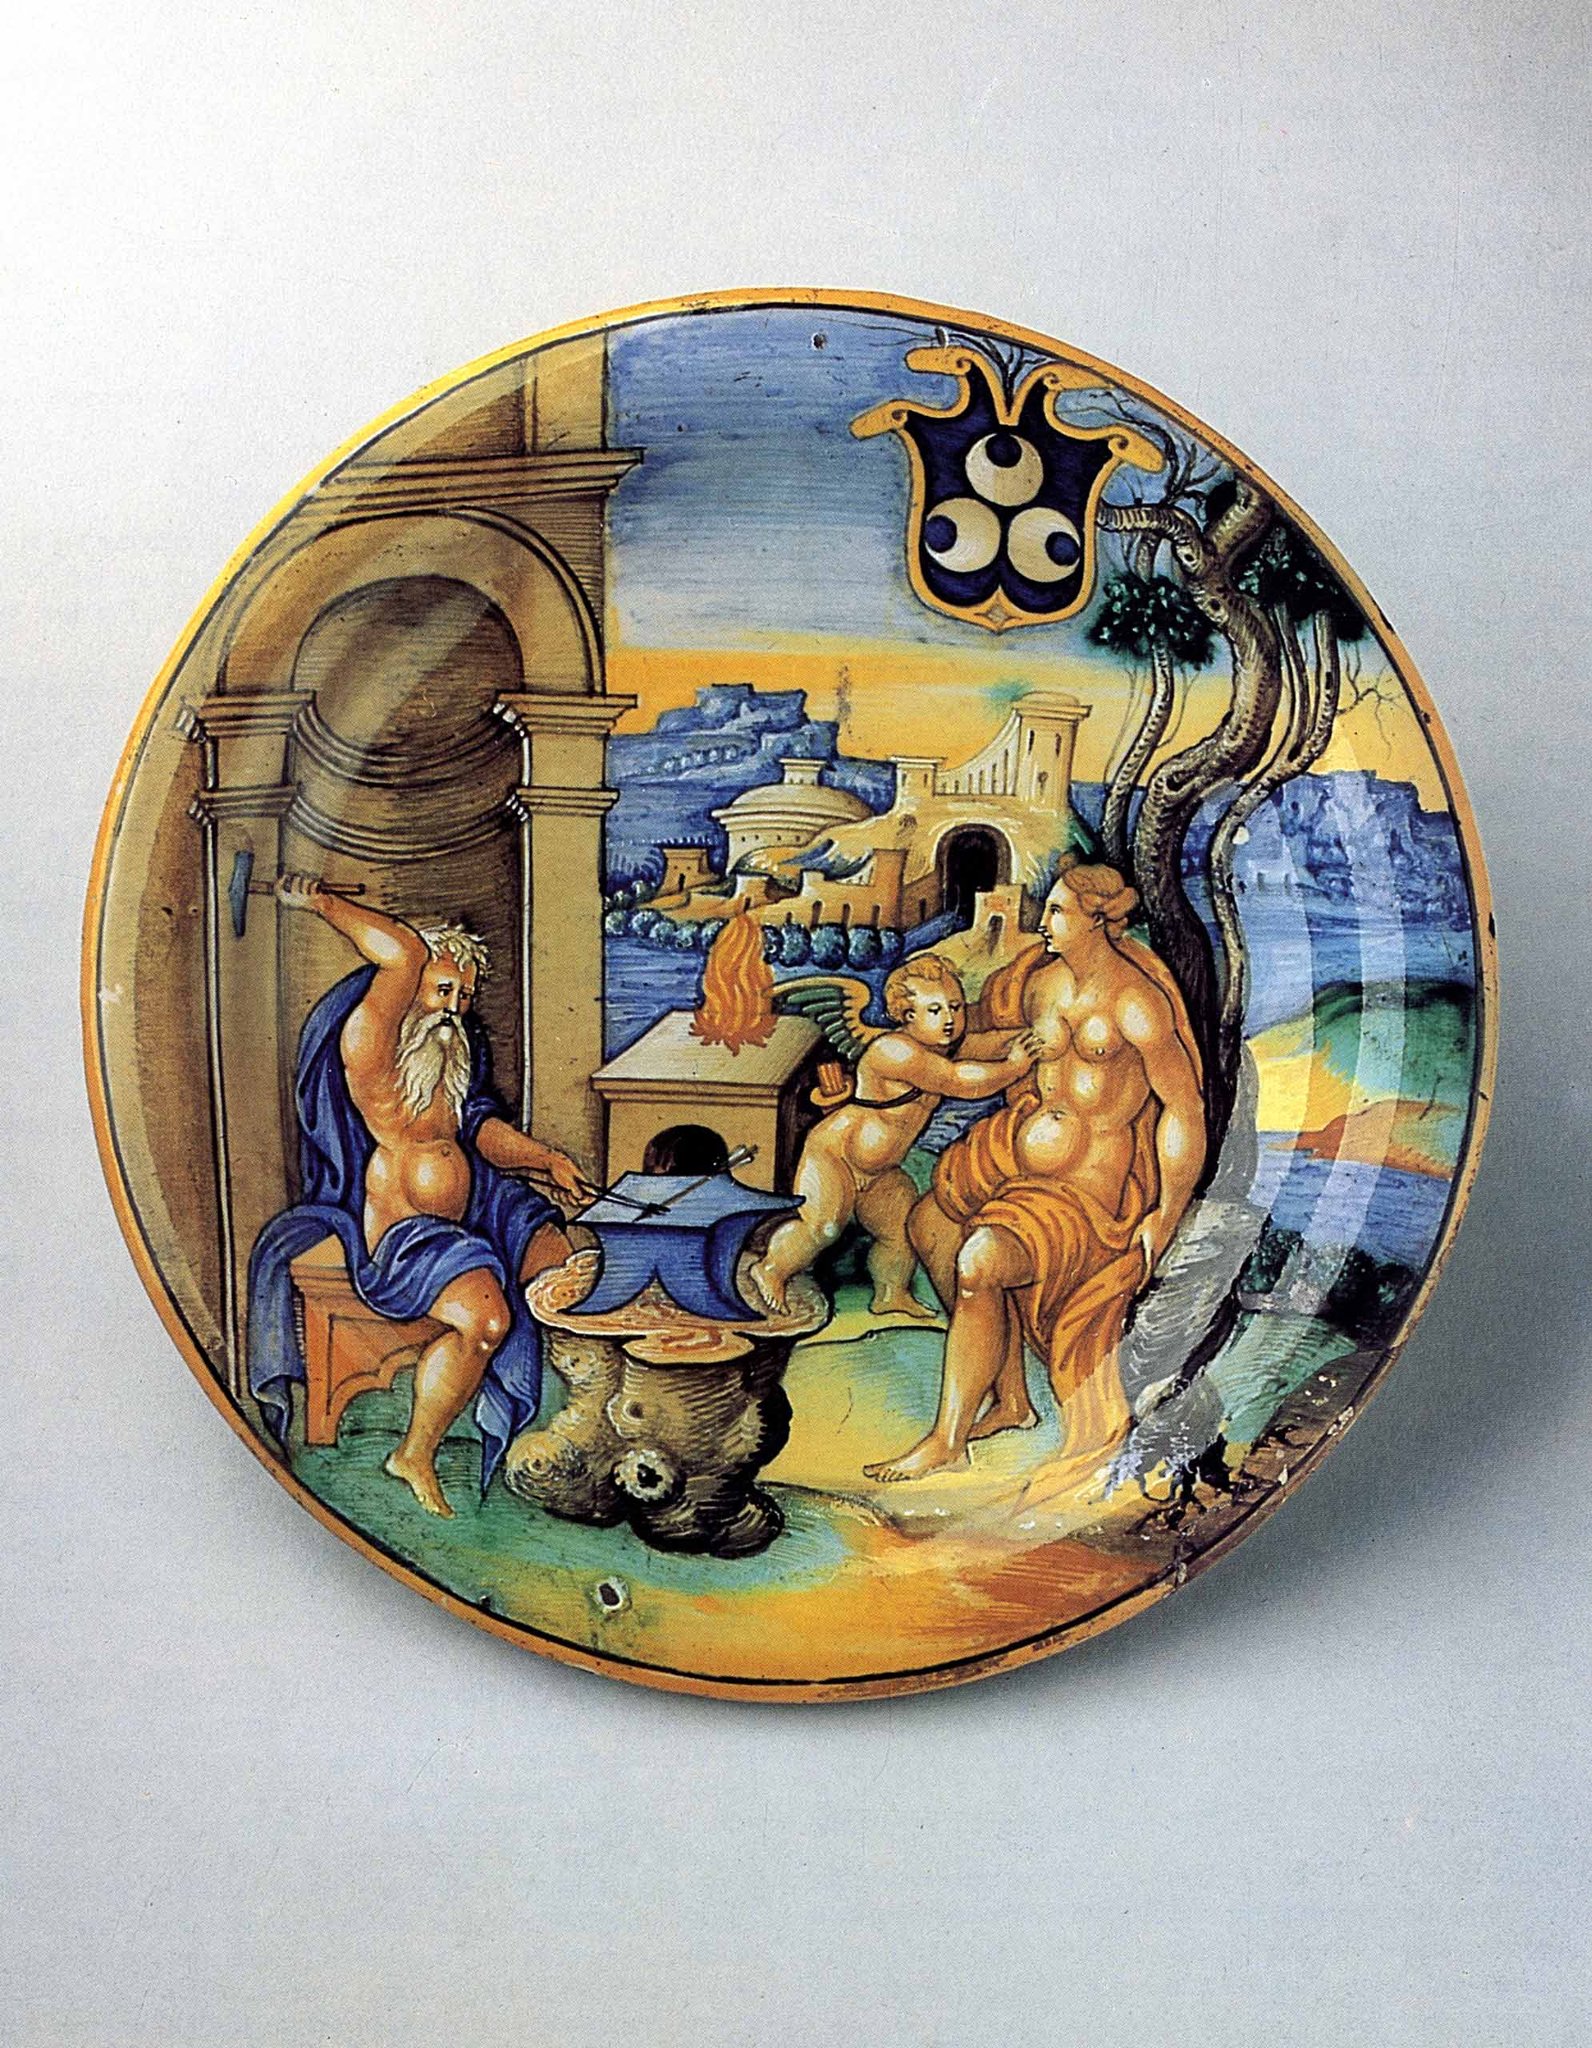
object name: dish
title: Dish (piatto): Vulcan forging an arrow for Cupid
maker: the "milan marsyas" painter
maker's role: artist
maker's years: 1500-1550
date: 1530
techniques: maiolica, glazing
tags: cupid,venus,vulcan